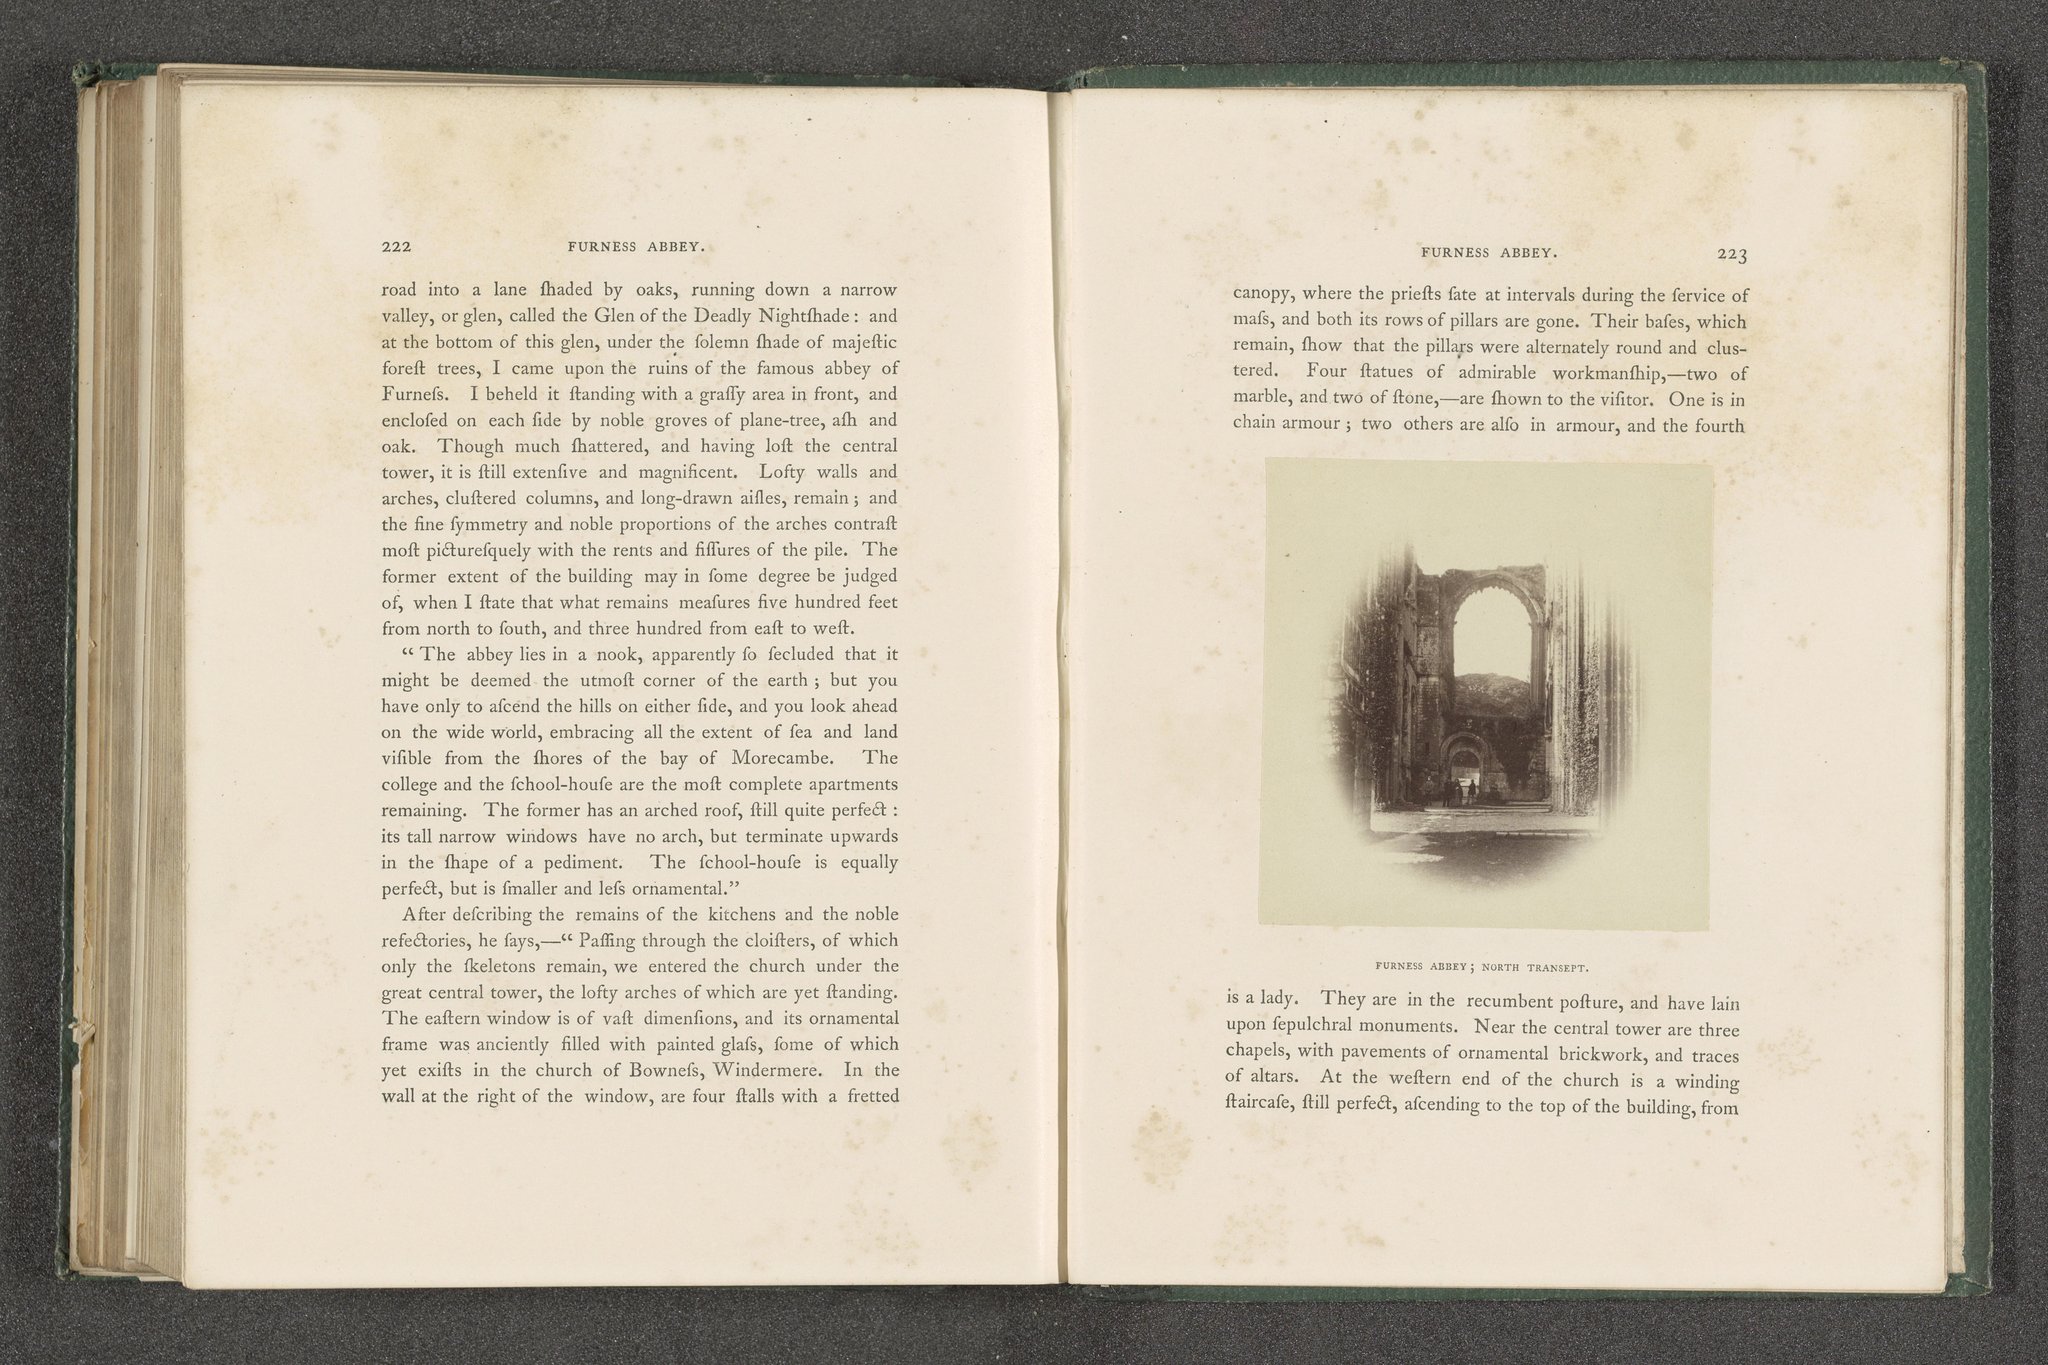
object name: page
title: Furness Abbey ; North Transept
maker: roger fenton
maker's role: fotograaf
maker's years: 1819-1869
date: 1852-1862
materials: photographic support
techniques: albumen print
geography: furness abbey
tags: parts of church interior: transept, ruin of church, monastery, etc.